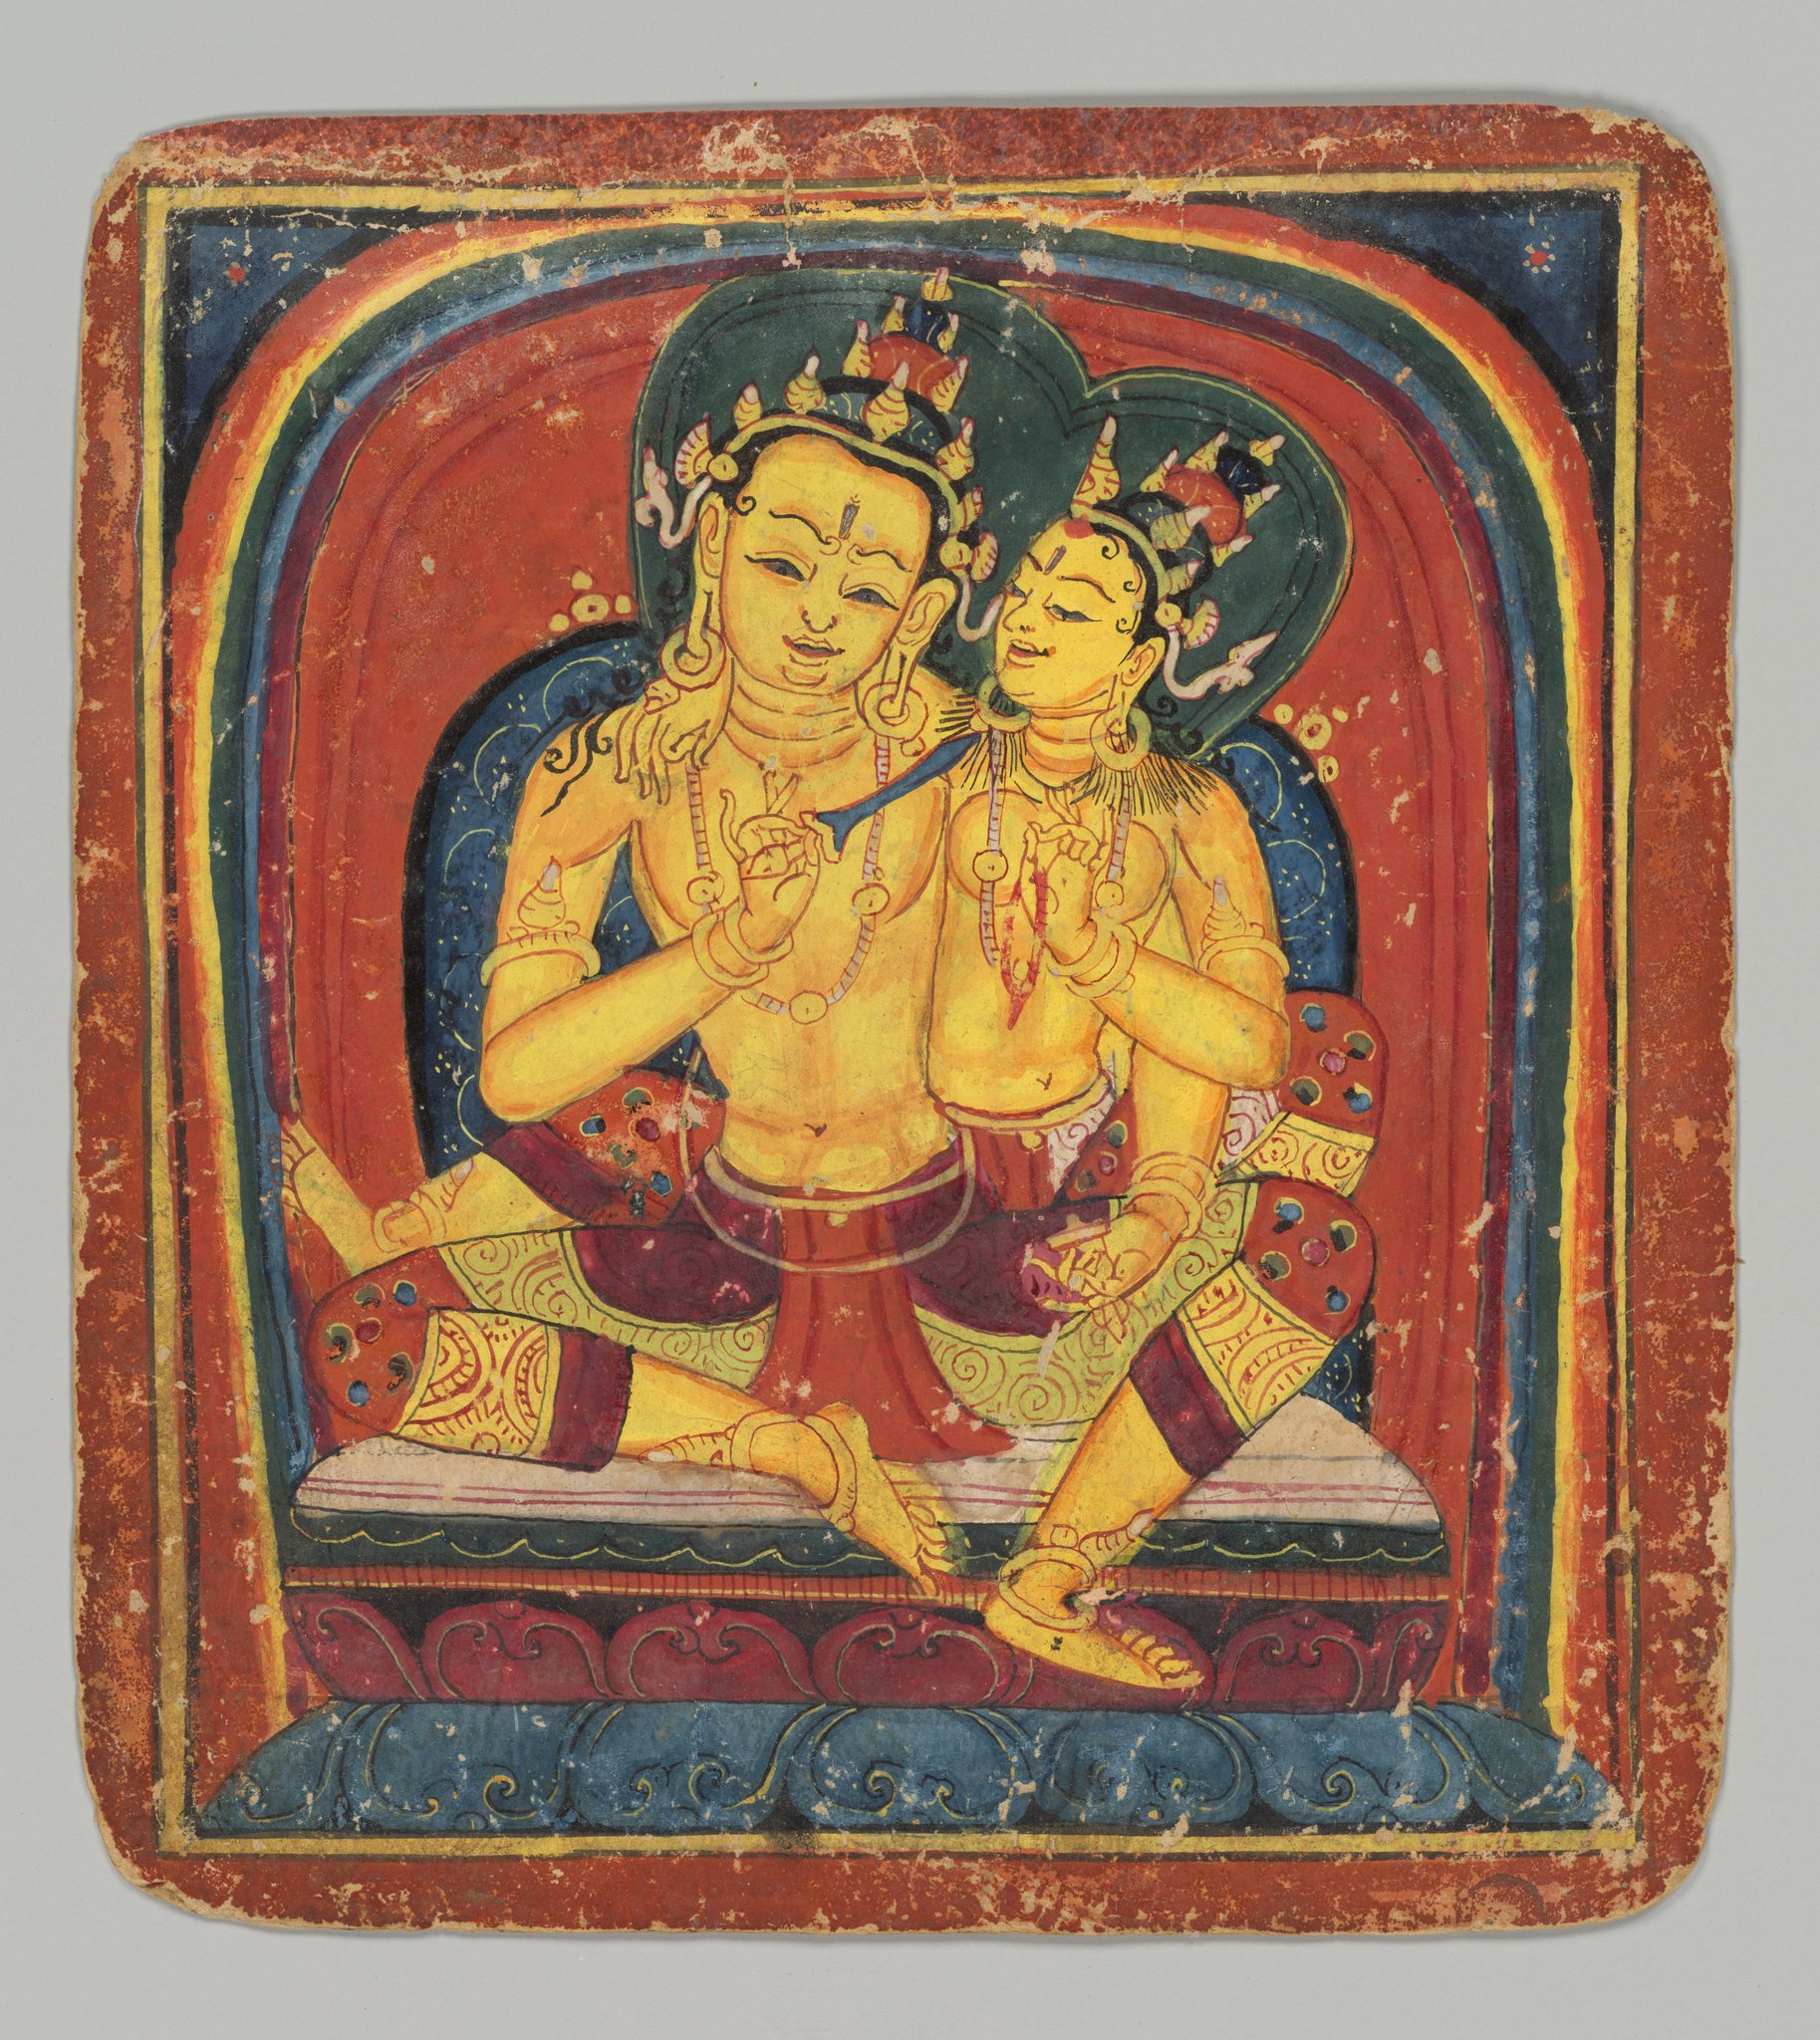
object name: initiation card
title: Initiation Card (Tsakalis): Akashagarbha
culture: tibetan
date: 1401-1433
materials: paper, watercolor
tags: deities